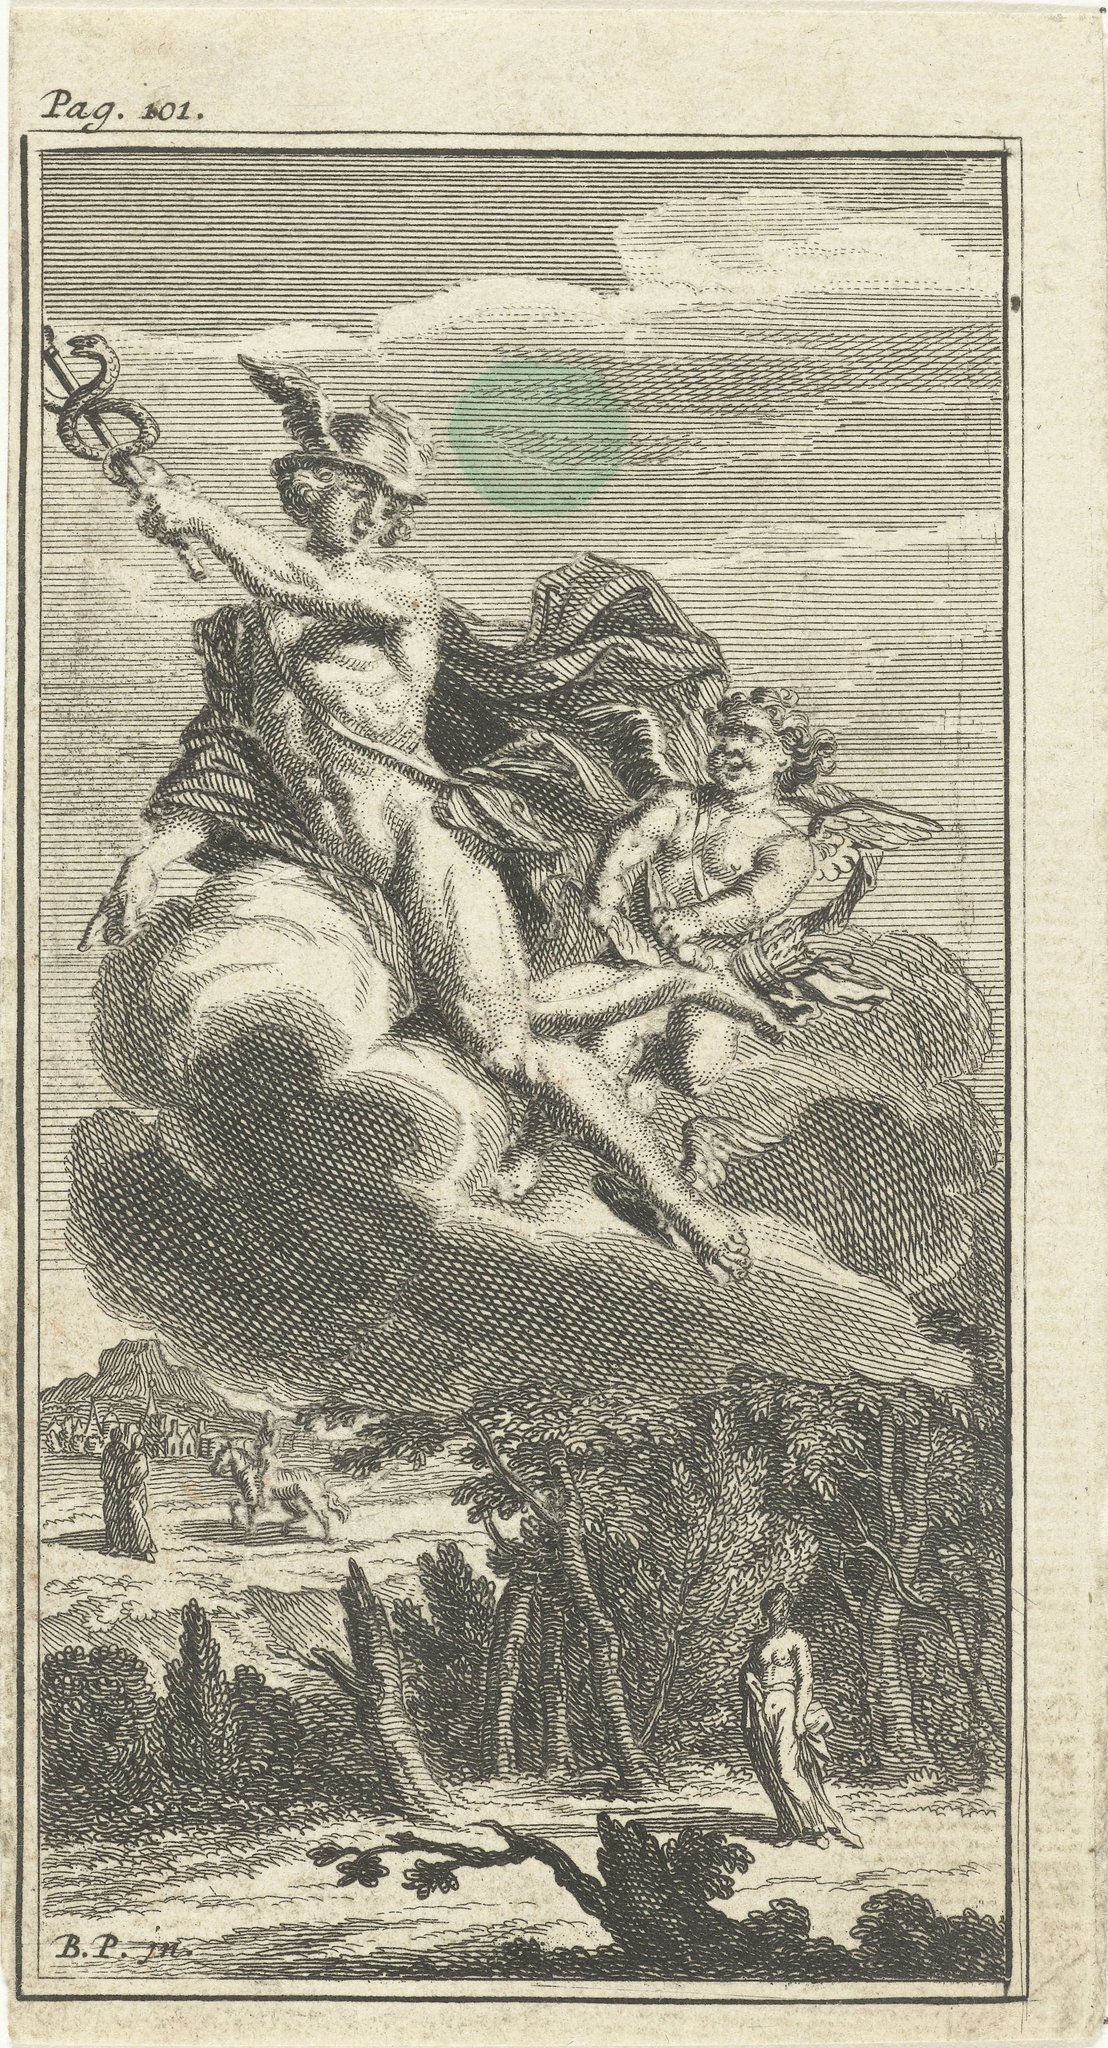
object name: book illustration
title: Mercurius en Cupido op een wolk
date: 1700-1750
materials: paper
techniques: etching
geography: amsterdam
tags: (story of) mercury (hermes), (story of) cupid, amor (eros)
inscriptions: collector's mark: Lugt 240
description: Illustratie voor: Bonaventure Des Perriers, Jean. Cymbalum mundi, ou Dialogues satyriques sur differens sujets. Amsterdam P. Marchand, 1711. Ook in latere edities van hetzelfde werk gebruikt.